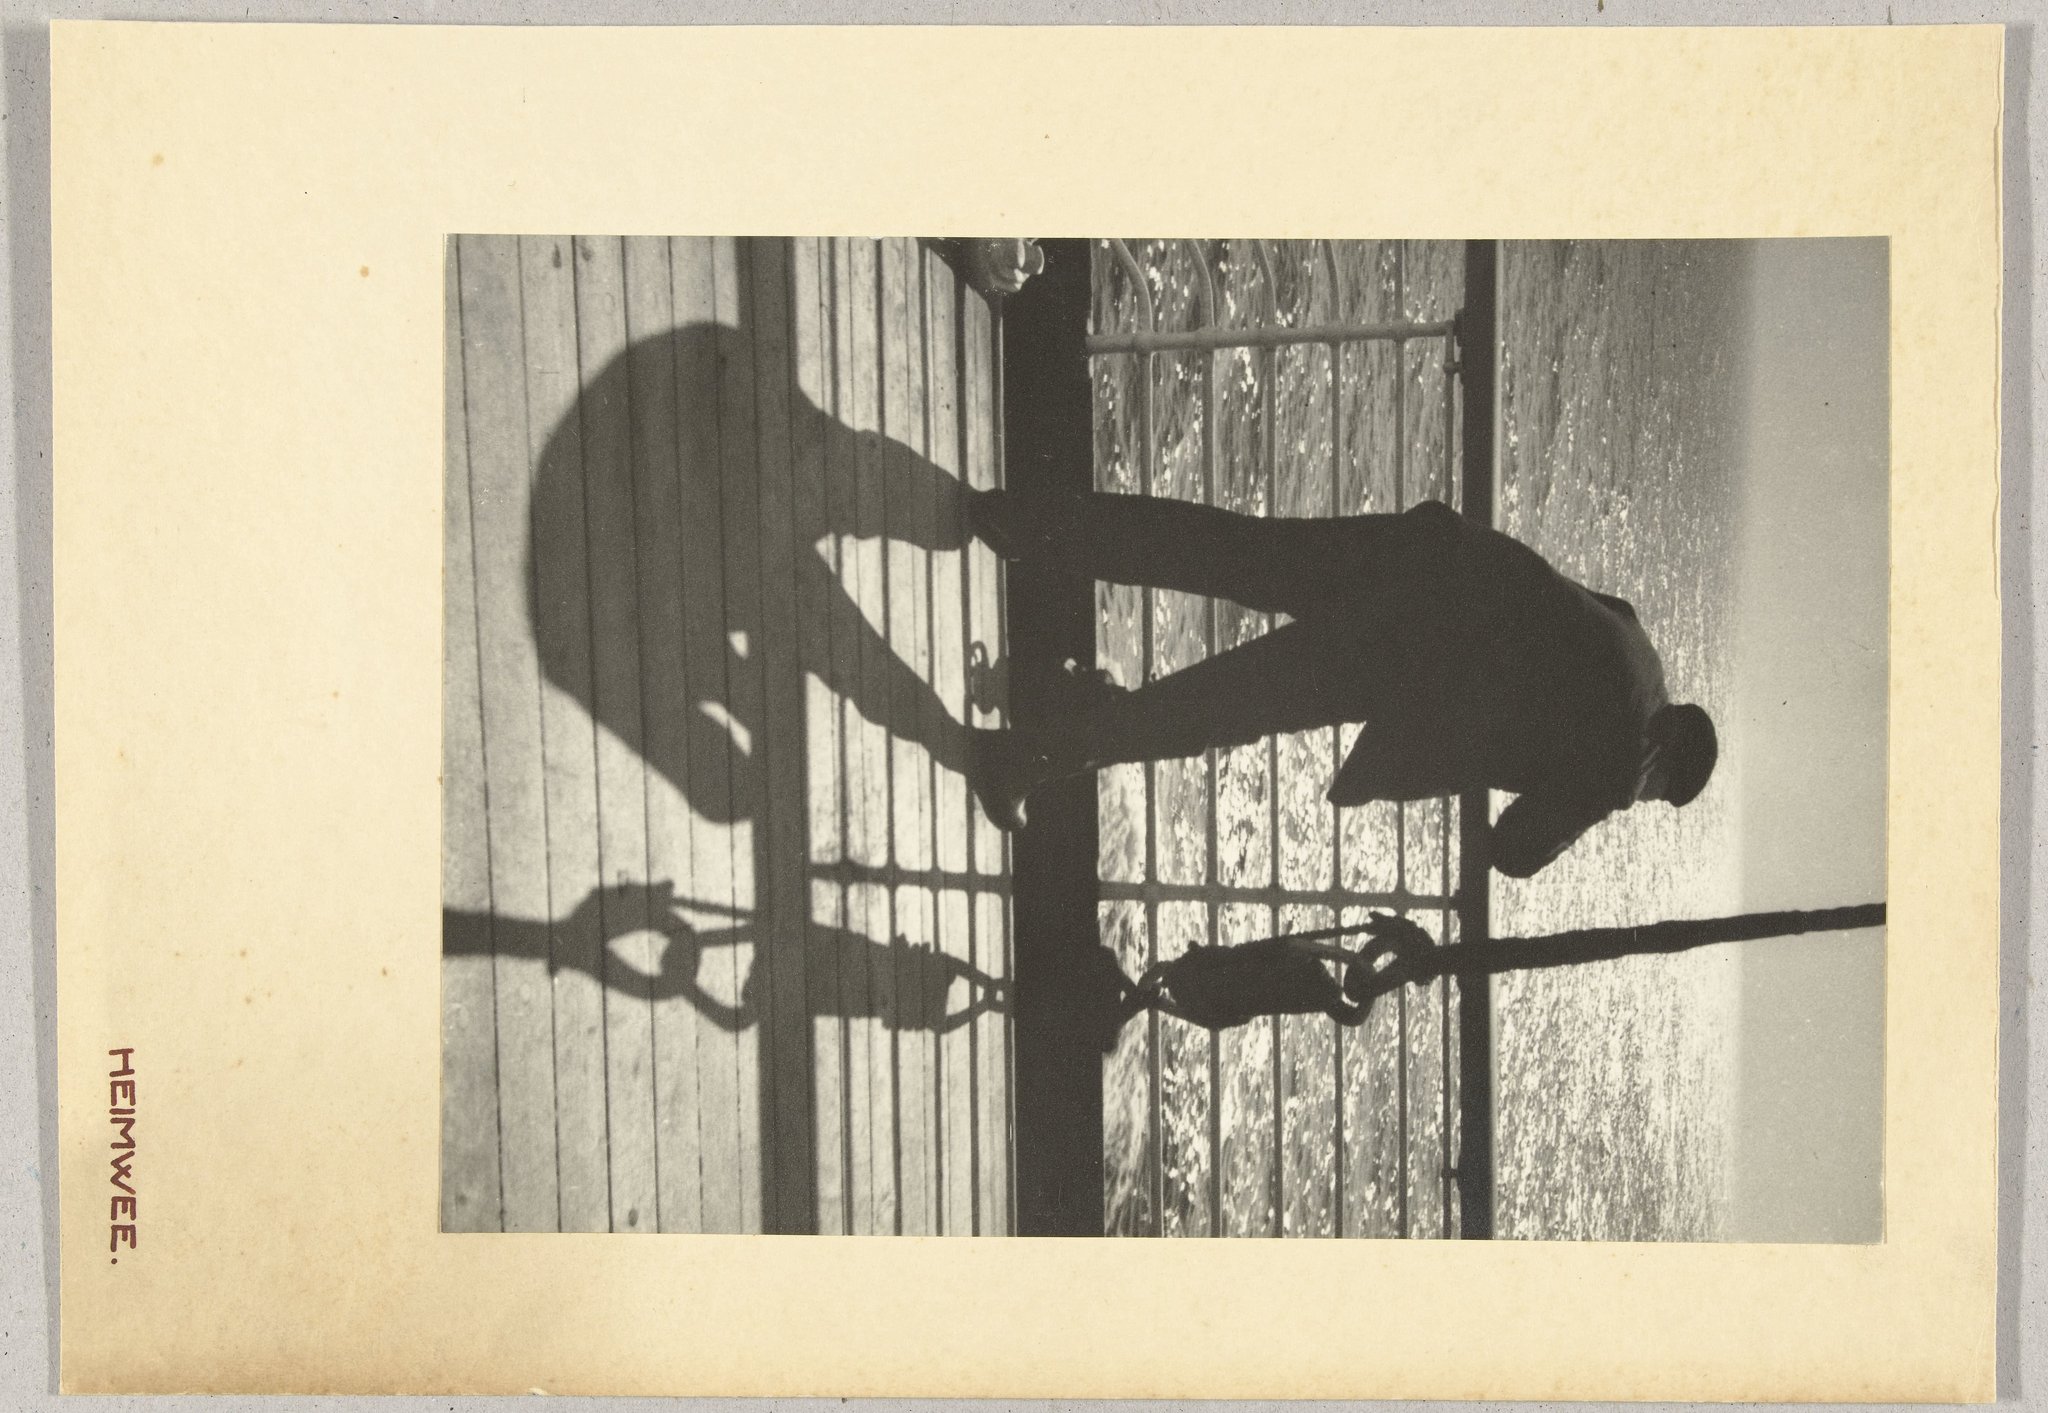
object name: photograph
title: Man die over de reling van een schip kijkt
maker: wouter cool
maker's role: engineer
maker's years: 1877-1947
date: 1936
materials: cardboard, paper, photographic support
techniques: gelatin silver print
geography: united states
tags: ships (in general)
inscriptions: title: ‘HEIMWEE.’